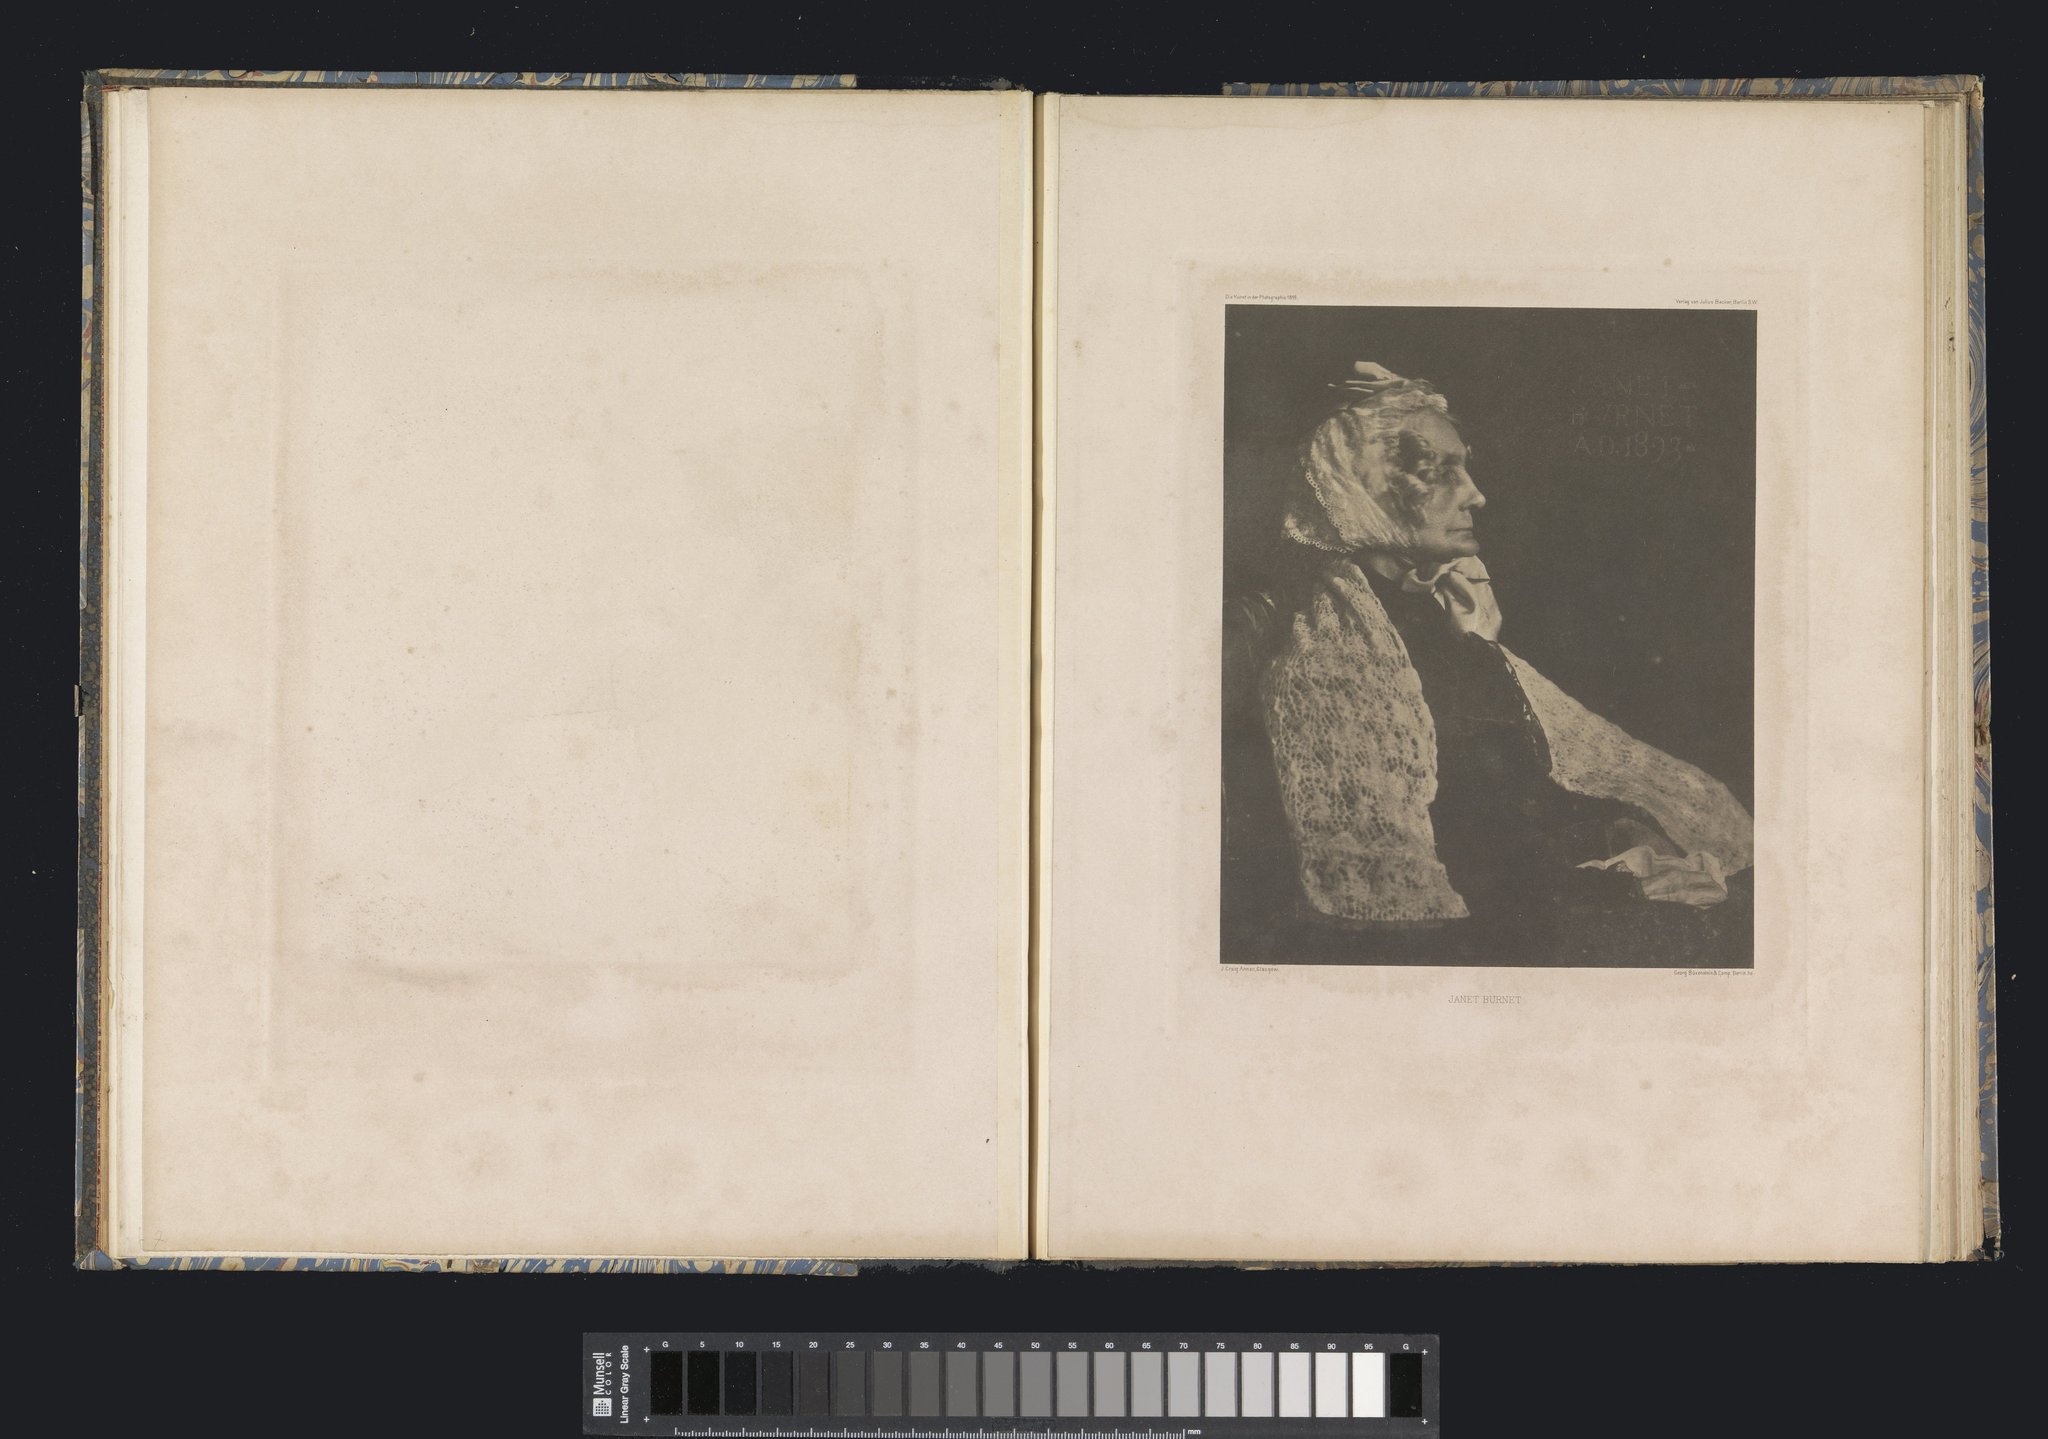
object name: page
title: Portret van Jane Burnett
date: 1893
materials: paper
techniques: photoaquatint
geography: glasgow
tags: old woman